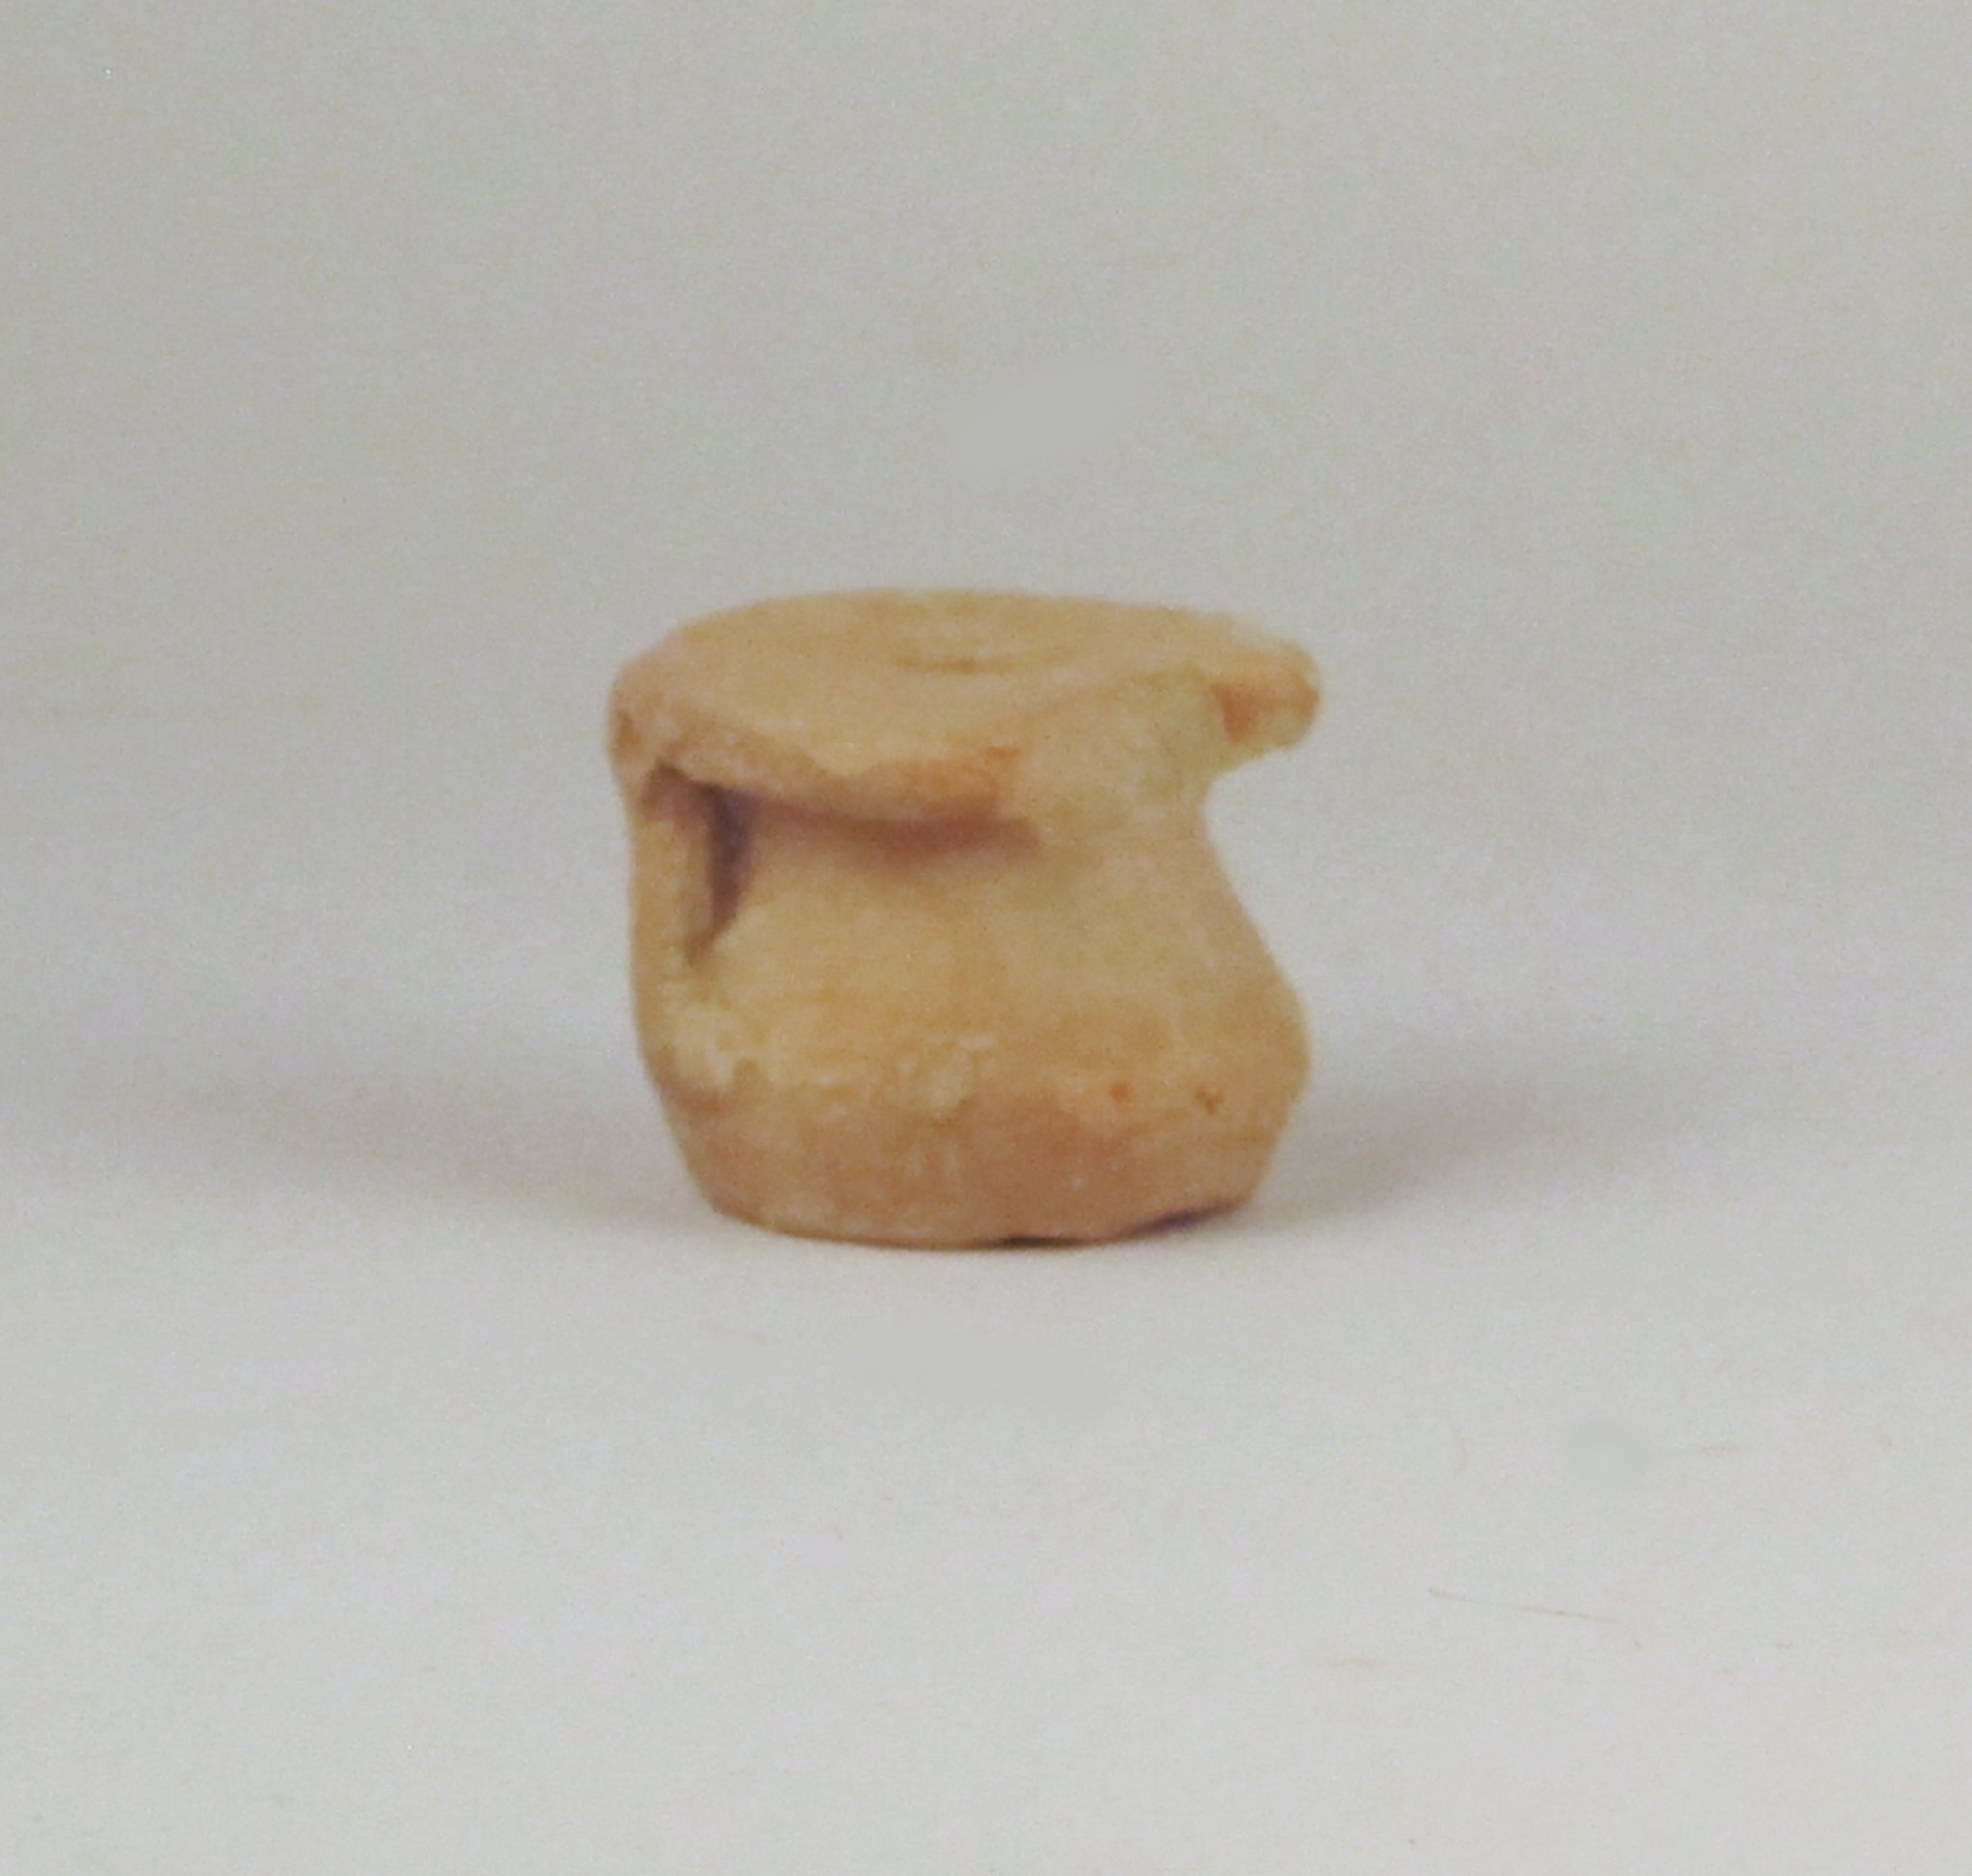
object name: vase fragment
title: Fragment of a miniature vase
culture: greek, laconian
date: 2000-1550 BCE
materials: terracotta